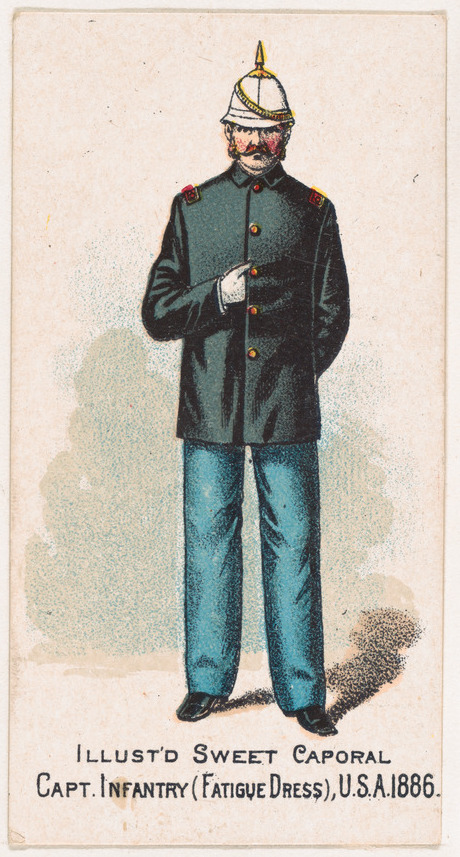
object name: print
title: Captain, Infantry, Fatigue Dress, United States Army, 1886, from the Military Series (N224) issued by Kinney Tobacco Company to promote Sweet Caporal Cigarettes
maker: kinney brothers tobacco company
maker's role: publisher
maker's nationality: american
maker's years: 1869-2011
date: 1888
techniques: color lithograph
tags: military,men